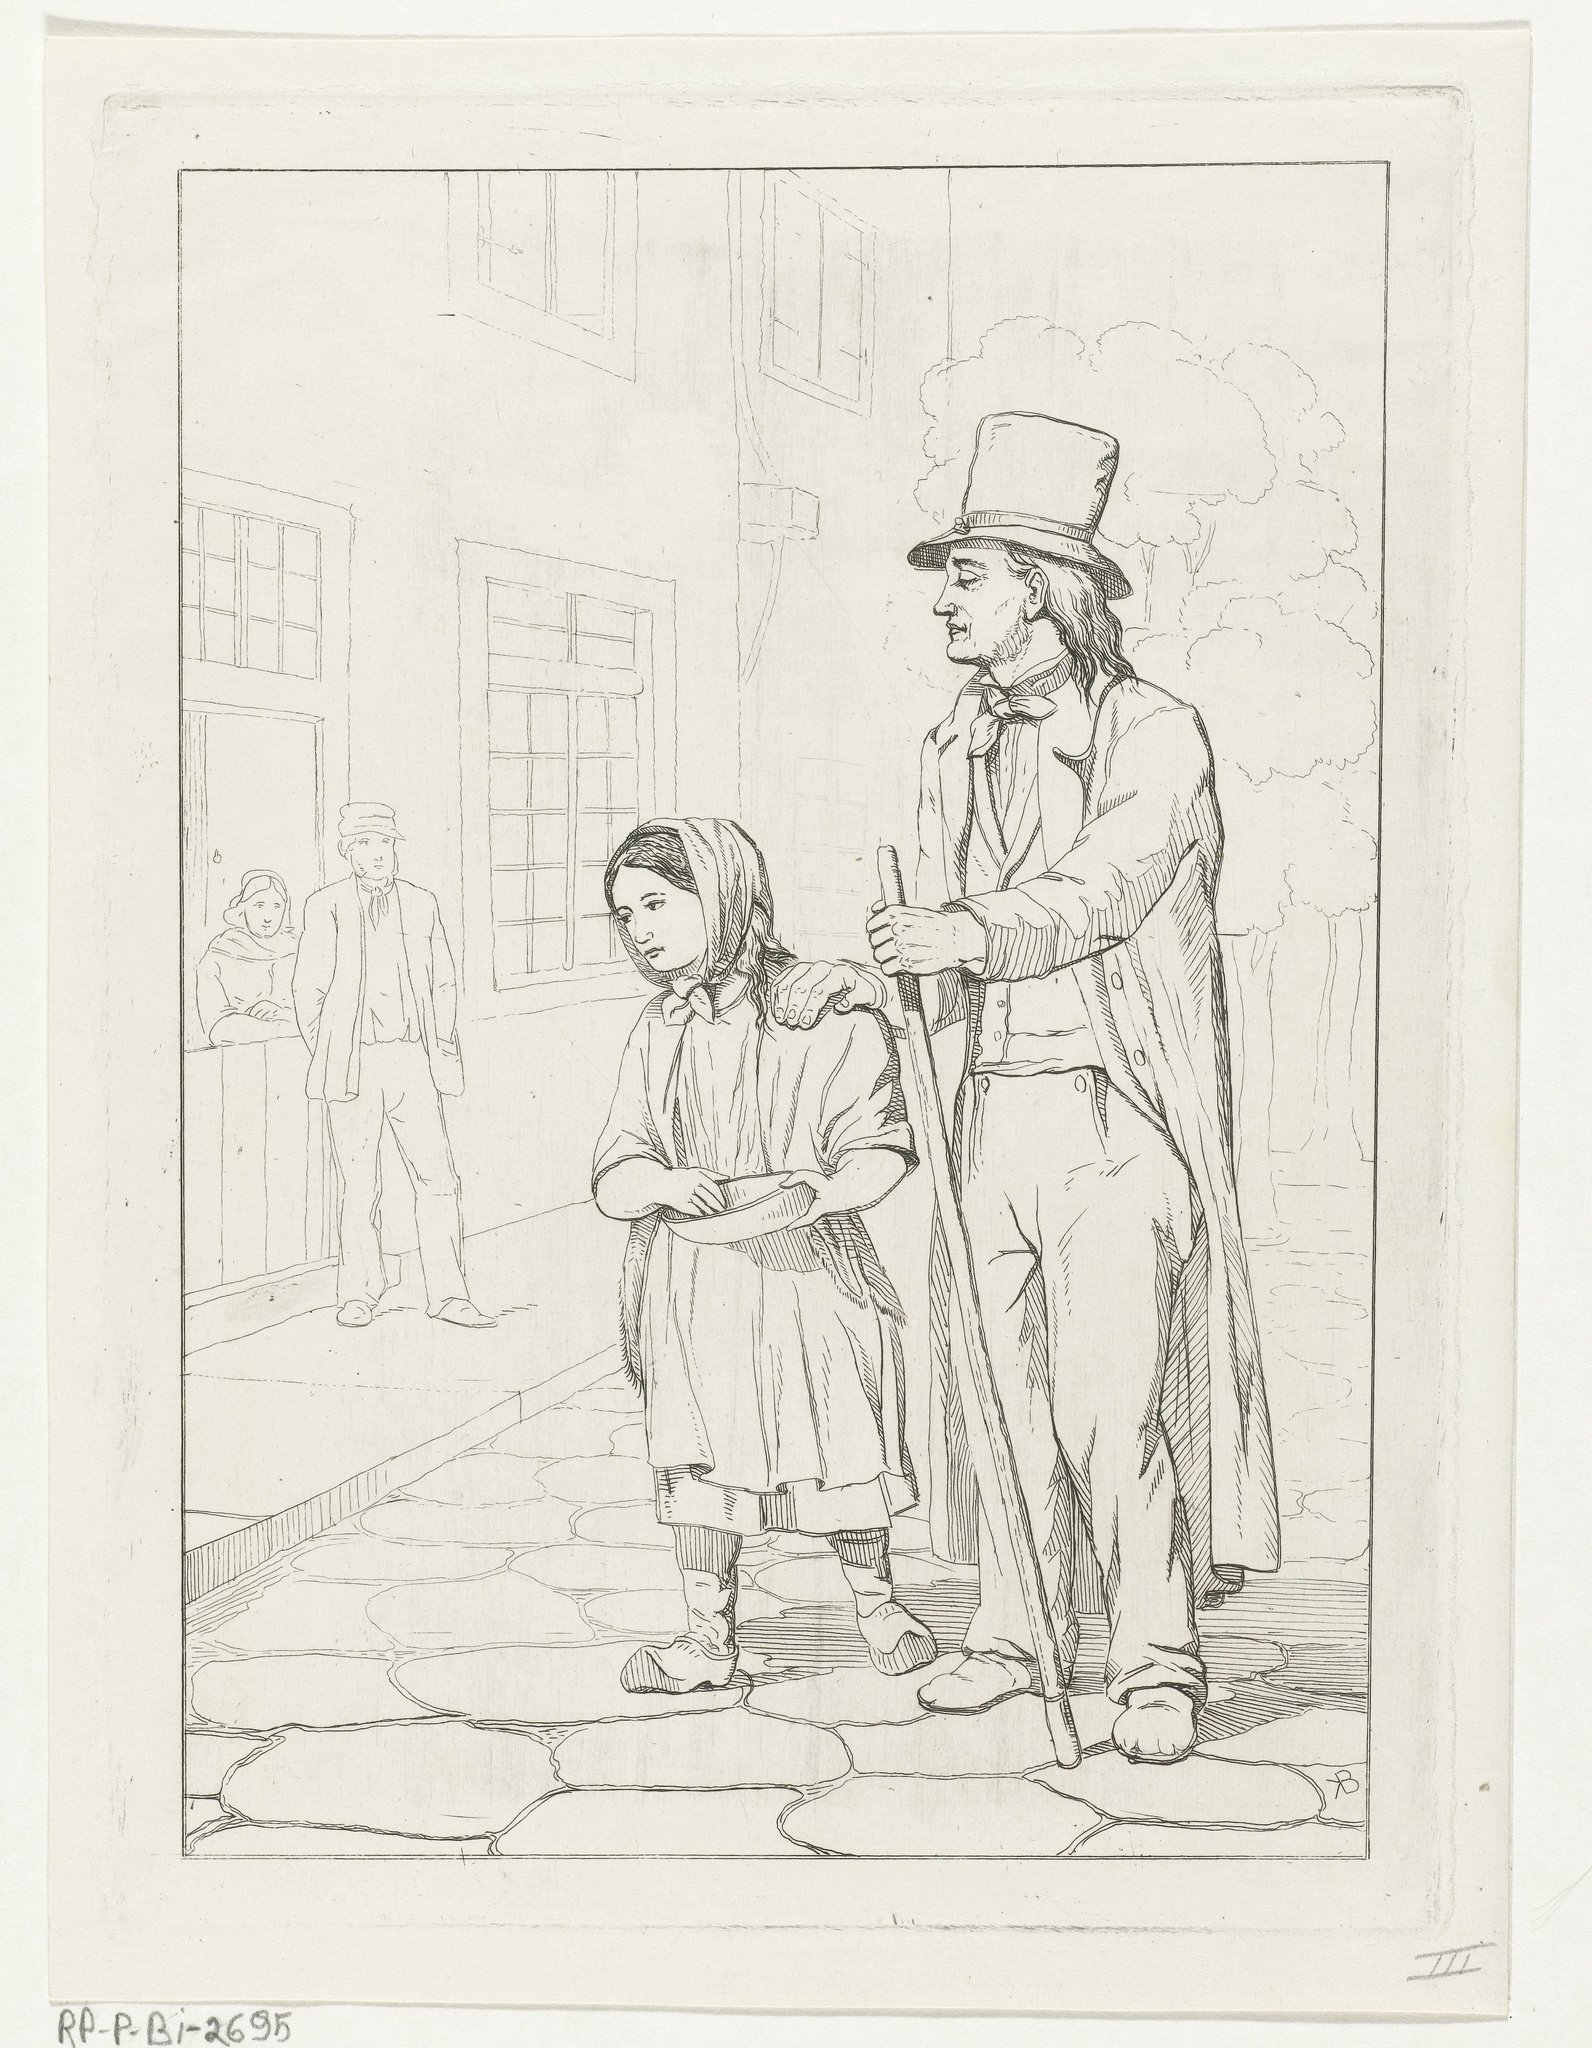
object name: print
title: Bedelaars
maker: karel frederik bombled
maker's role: draughtsman, print maker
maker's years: 1822-1902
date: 1832-1902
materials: paper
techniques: etching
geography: netherlands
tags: 'fahrende leute', vagrants, begging bowl, beggar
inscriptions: collector's mark: Lugt 2228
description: Een man en een jong meisje, alle twee in lompen gekleed, lopen langs een geplaveide straat. Het meisje heeft een bedelkom bij en lijkt zich naar een paar te begeven dat vanaf de stoep toekijkt.